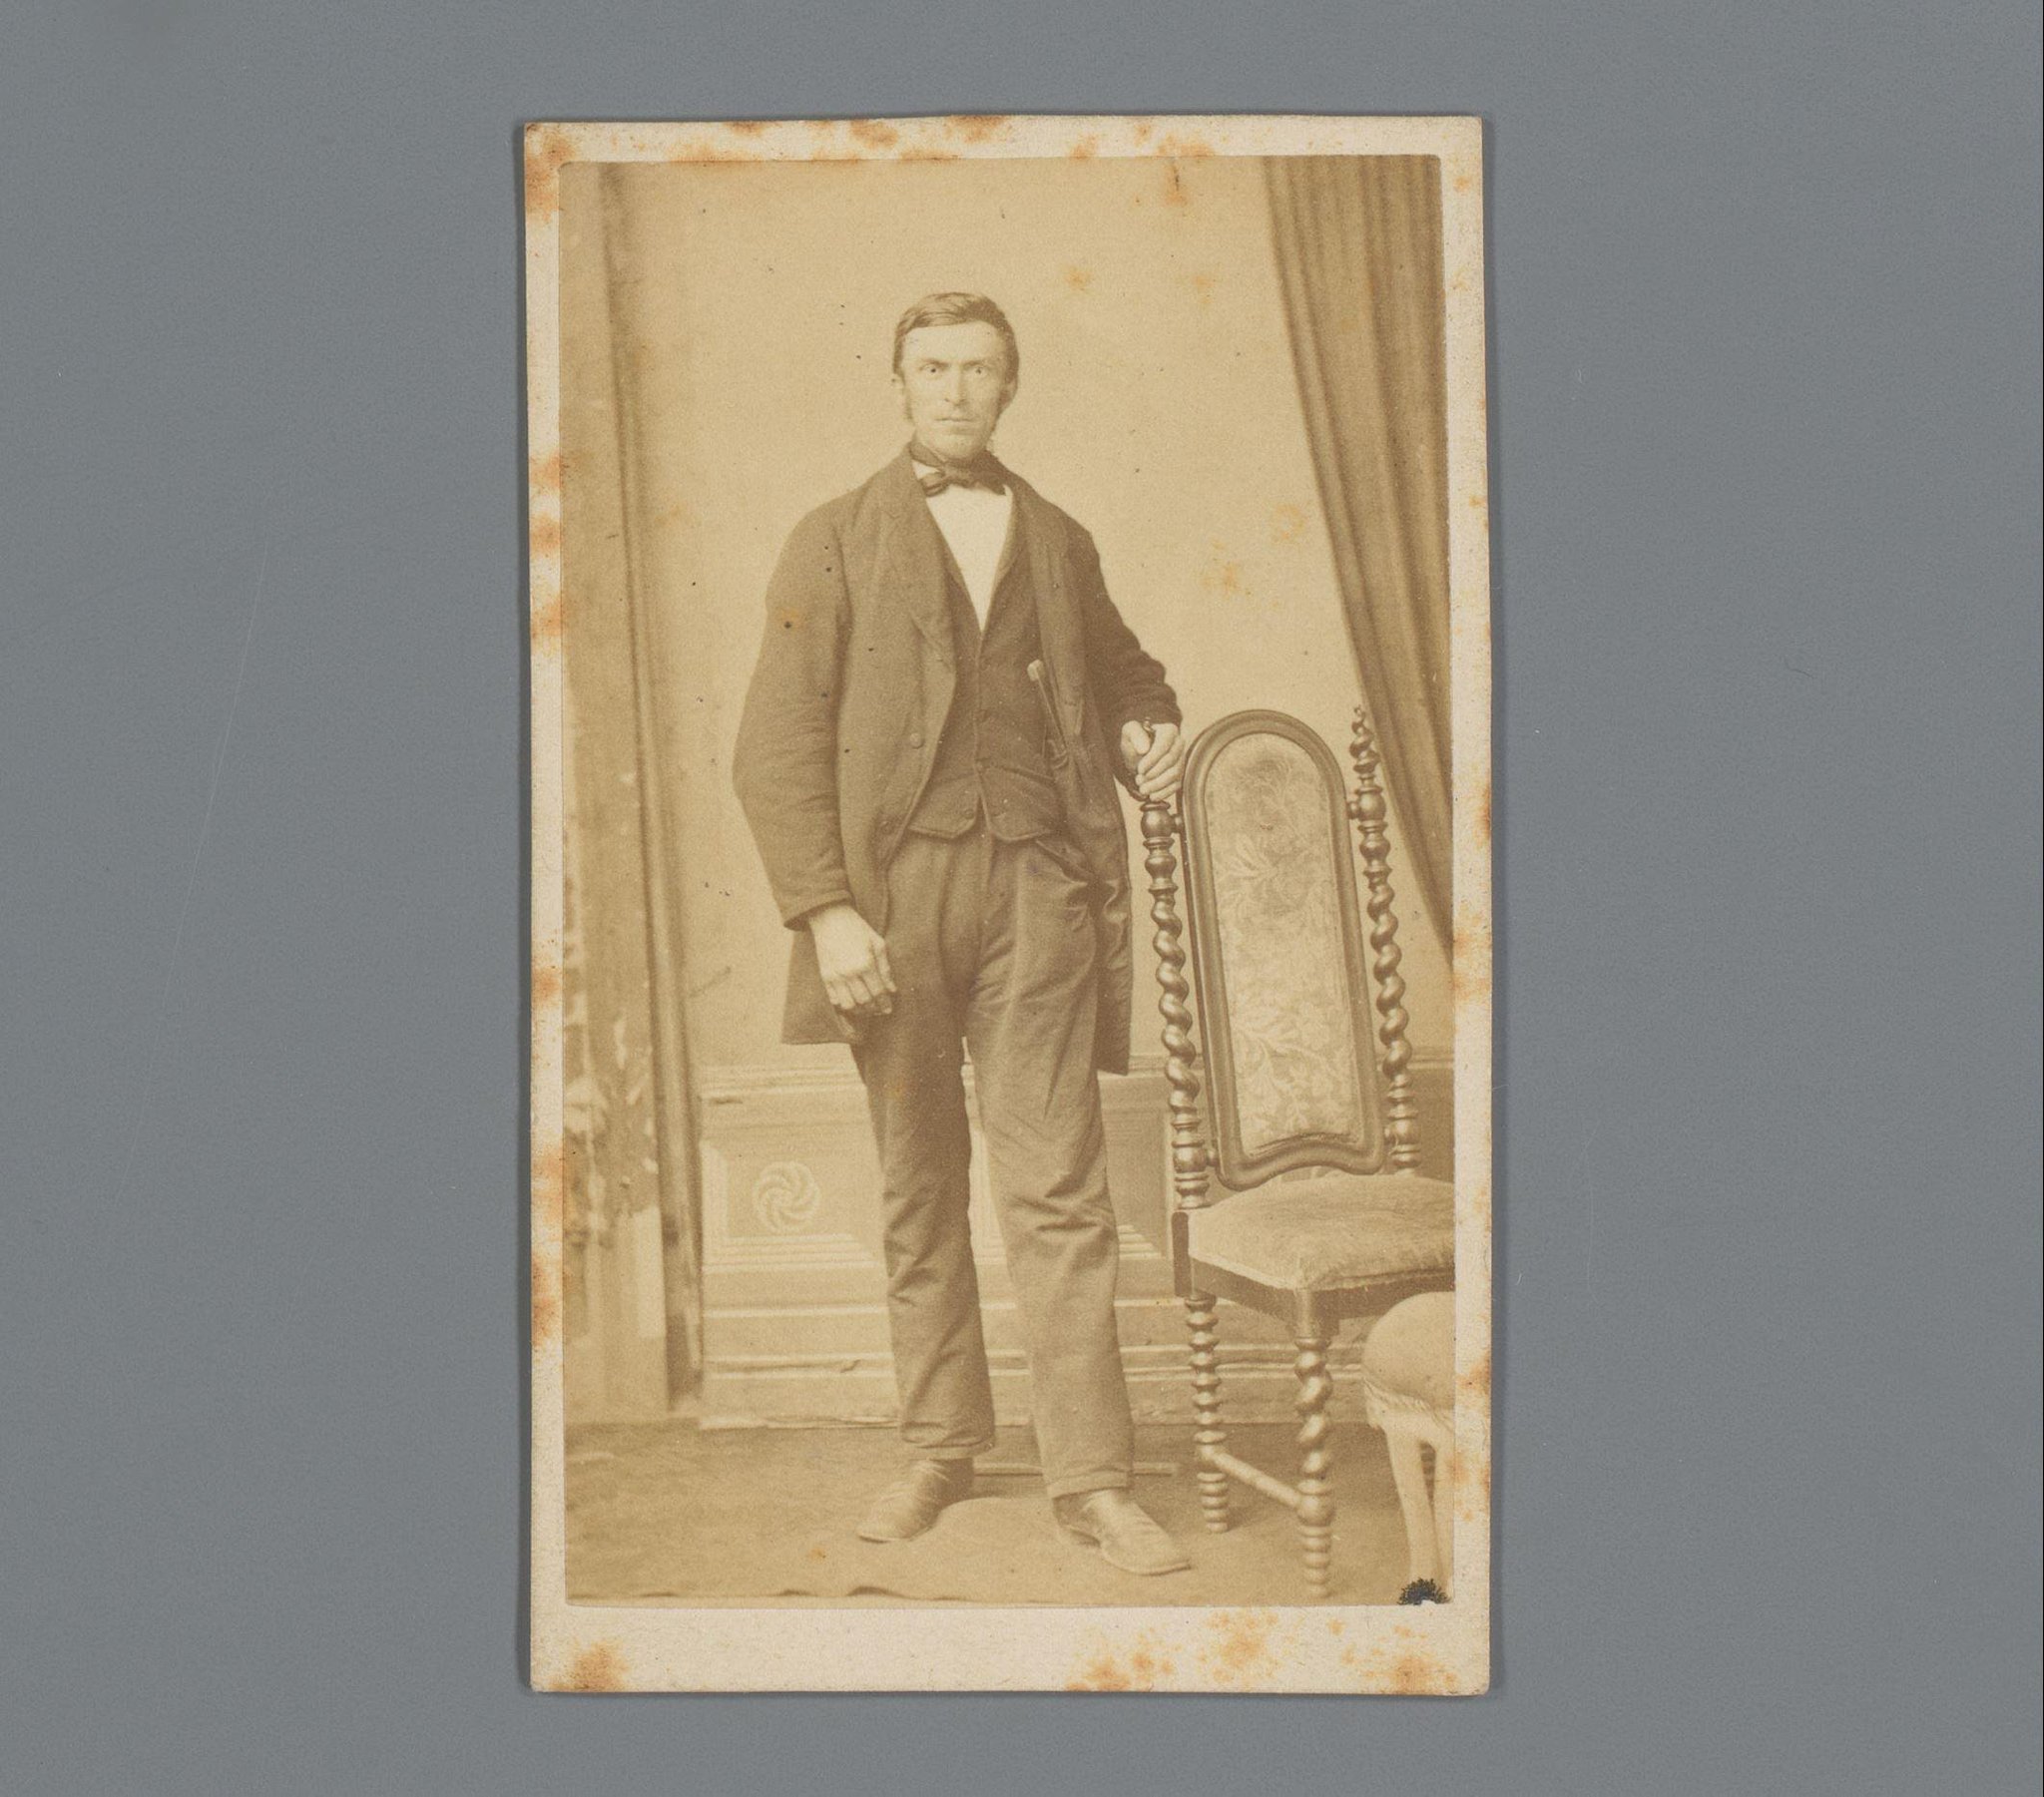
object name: photograph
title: Portret van een onbekende man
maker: israël david kiek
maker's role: fotograaf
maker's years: 1811-1899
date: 1855-1896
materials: cardboard, paper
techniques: albumen print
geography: leiden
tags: adult man, anonymous historical person portrayed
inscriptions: inscription: ‘bij het Station/ LEIDEN.’